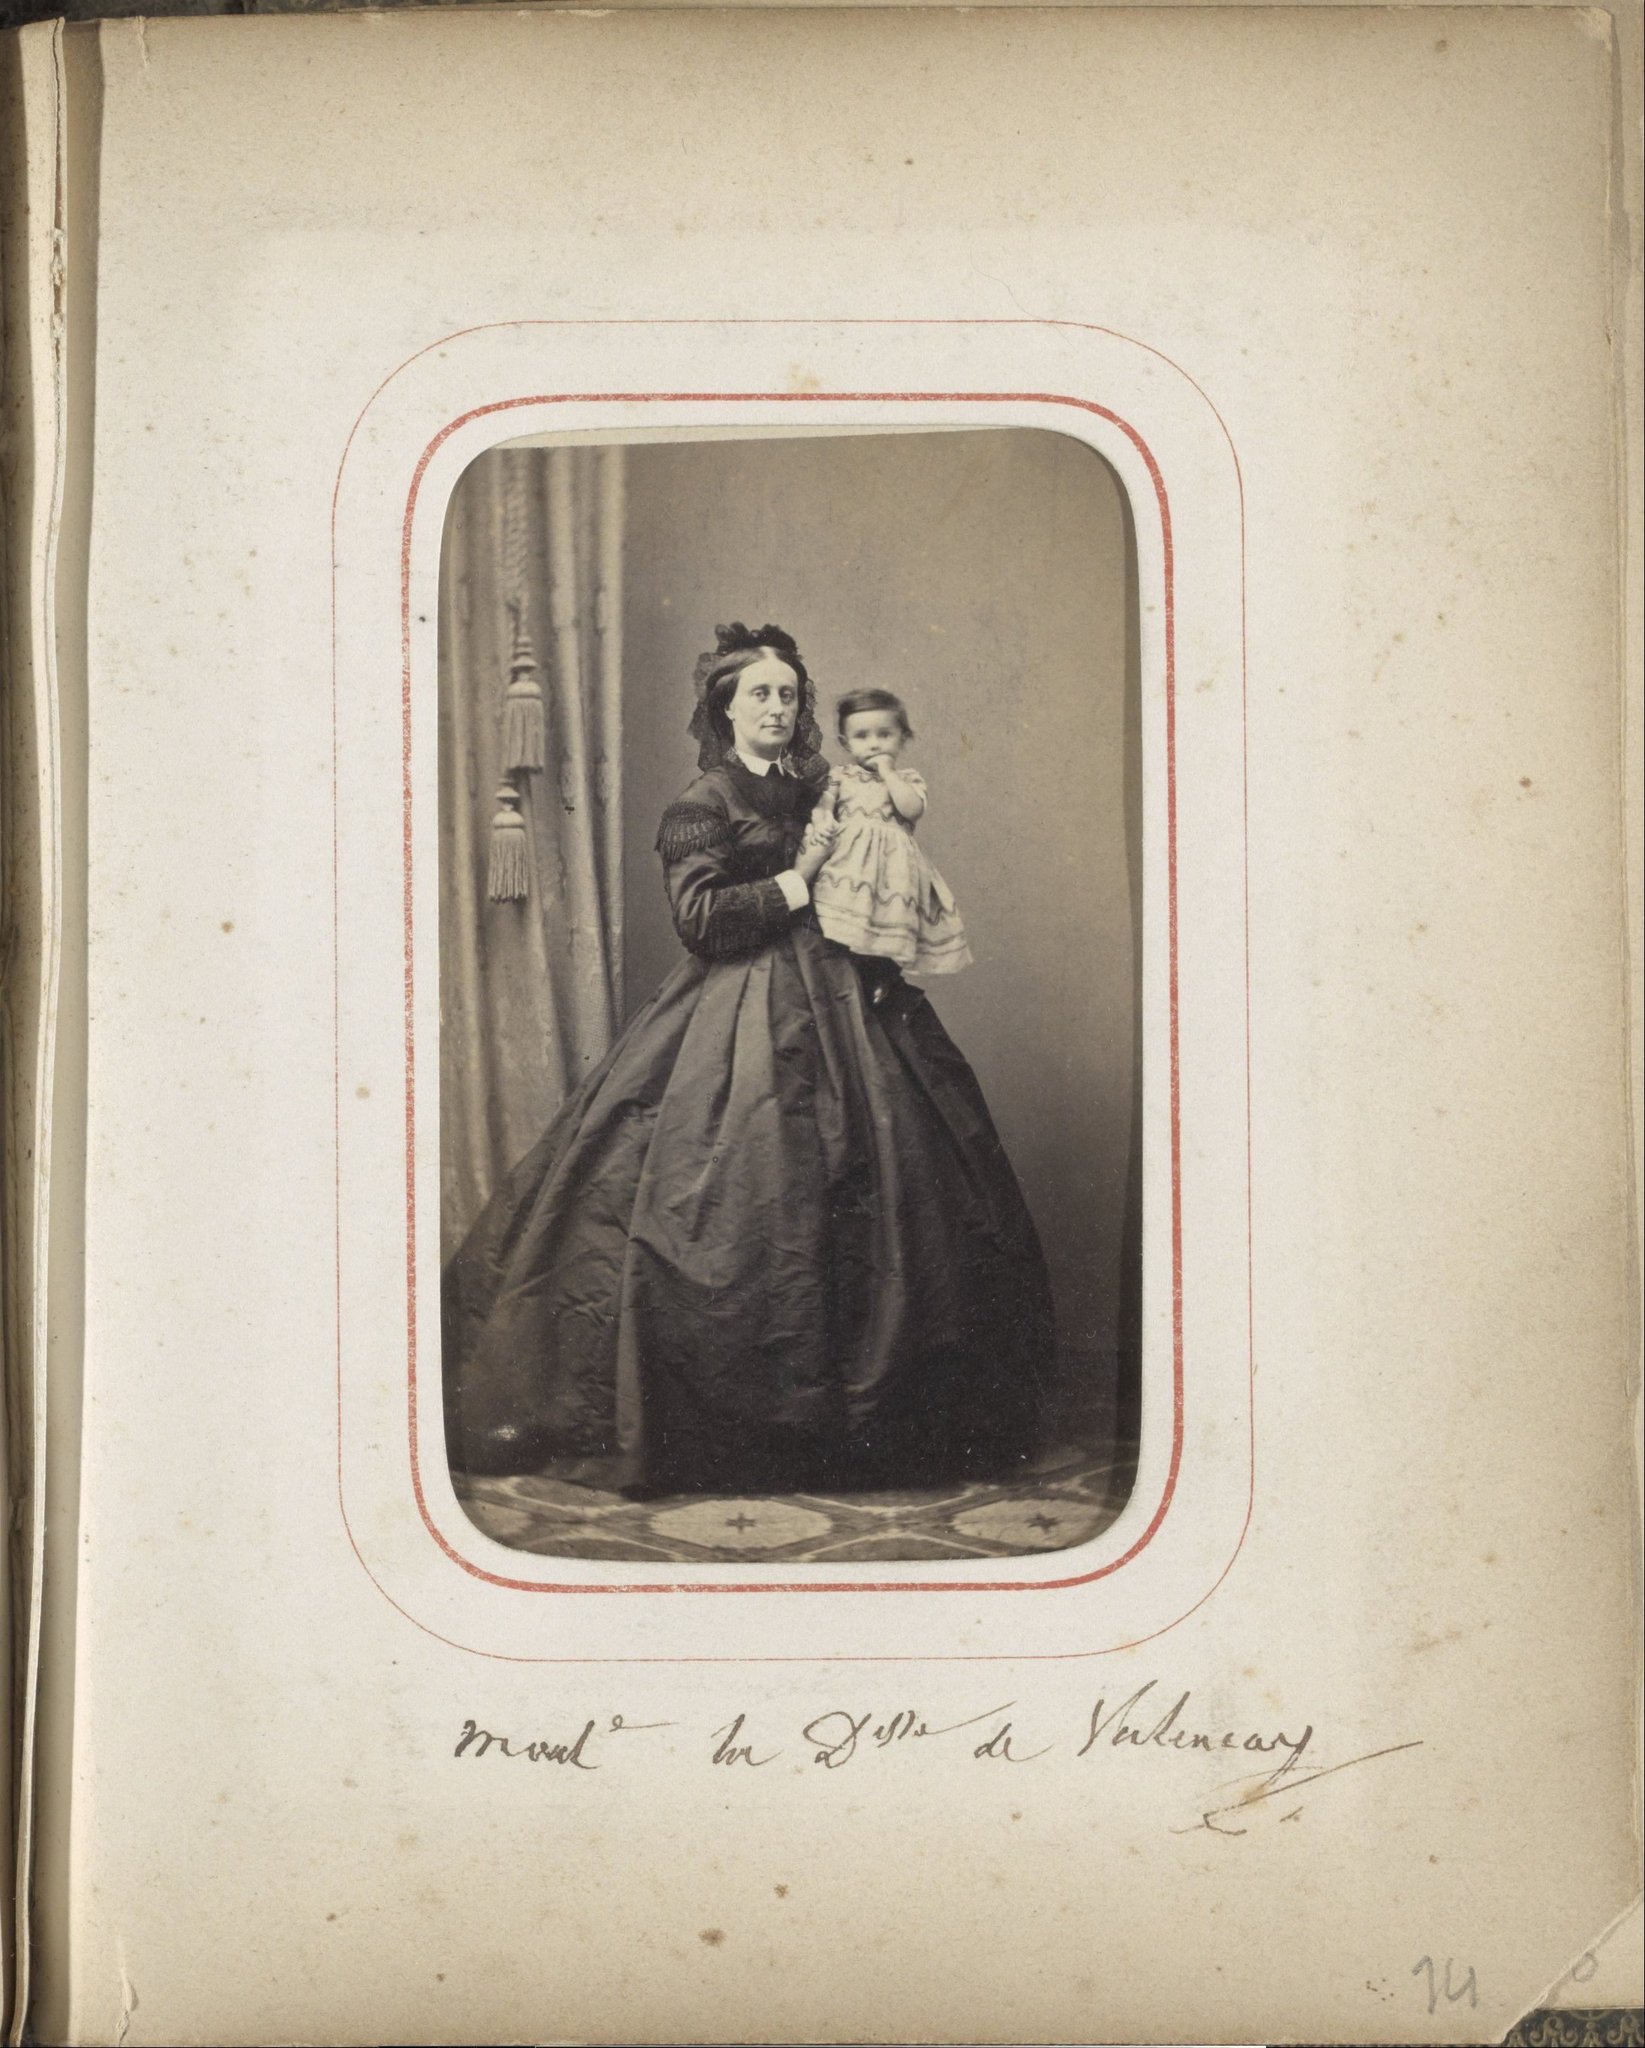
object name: carte de visite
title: Portret van jonkvrouw De Valencay met Dolly op de arm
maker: a. schamberg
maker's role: print maker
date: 1860-1865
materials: cardboard, paper, photographic support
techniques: albumen print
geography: germany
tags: studio requisites ~ photographer, head-gear, historical persons, styles of hairdress - aa - ~ women, mother and baby or young child, dress, gown, tot, toddler ~ the ages of man, germany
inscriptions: name: ‘Mad.e la D.elle de Valencay’, address: ‘Ober Hospital Str. No. 8’, name: ‘A. Schamberg's Lithogr. Anstalt u. Photographisches Atelier’